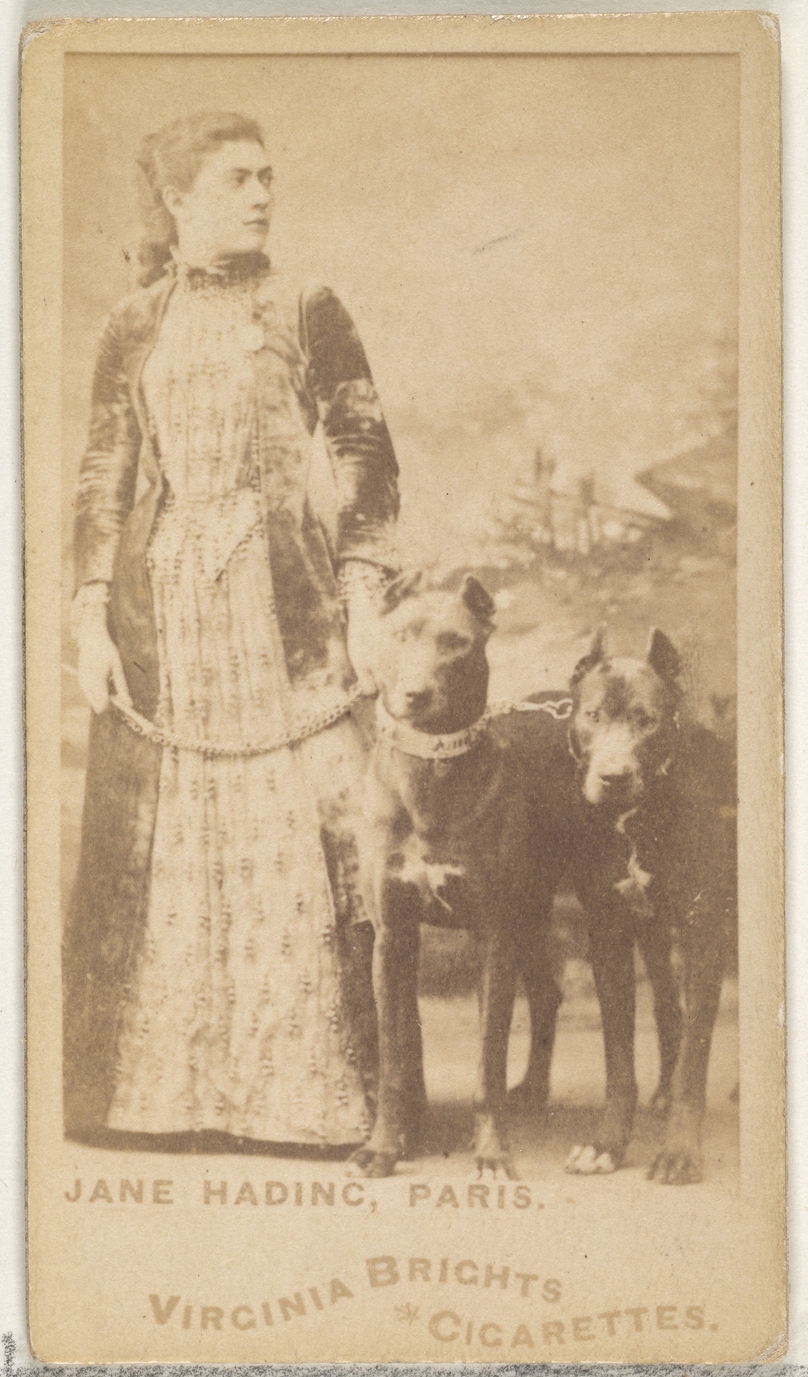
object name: photograph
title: Jane Hading, Paris, from the Actors and Actresses series (N45, Type 1) for Virginia Brights Cigarettes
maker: allen & ginter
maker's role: publisher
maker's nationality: american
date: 1888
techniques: albumen silver print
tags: portraits,women,dogs,actresses